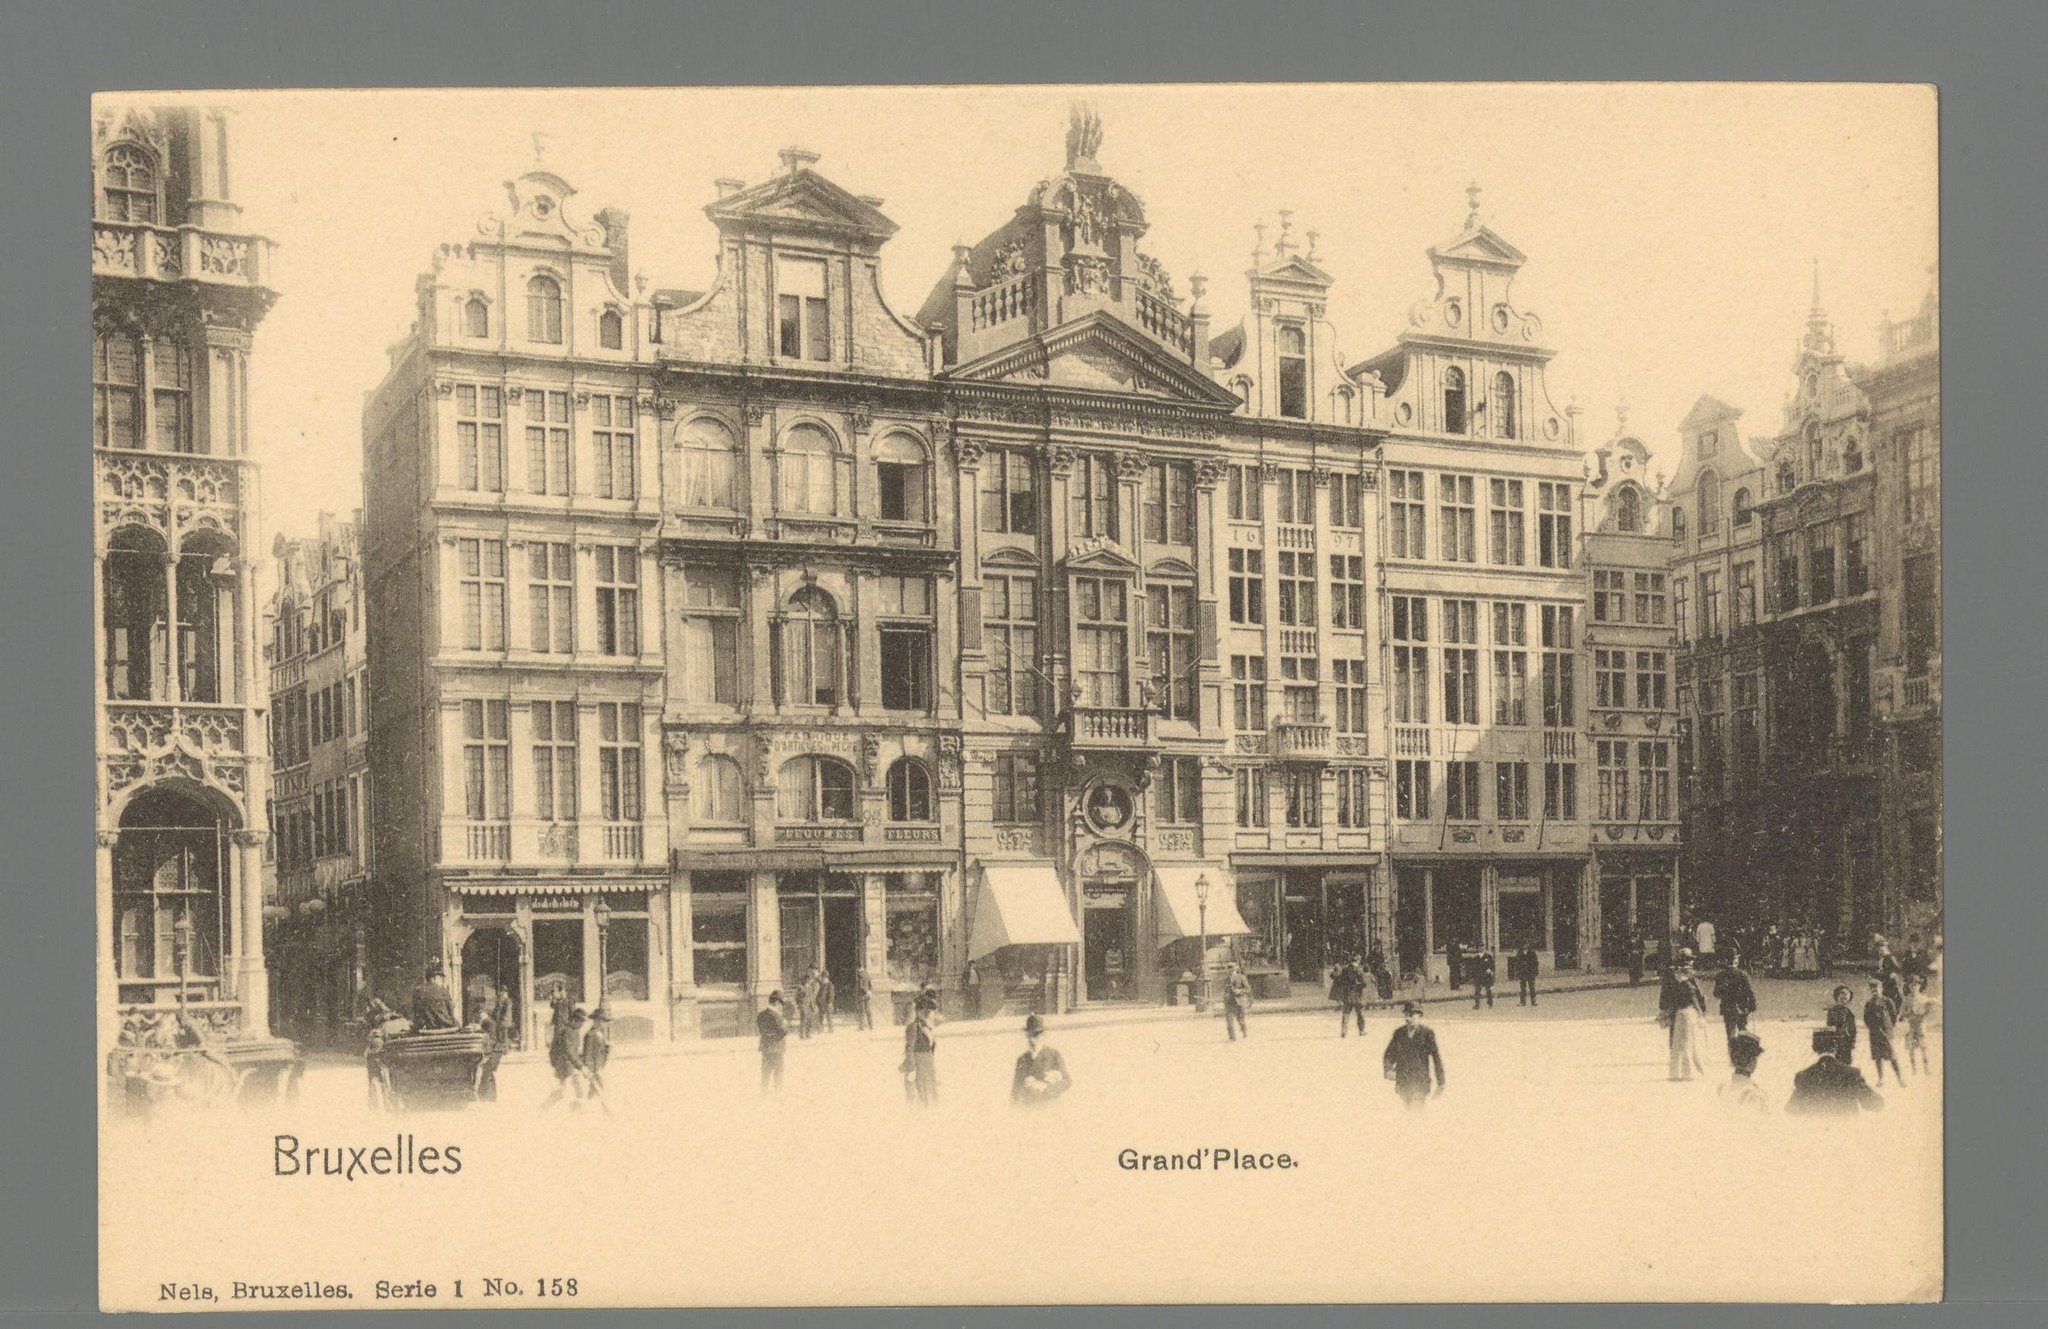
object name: ansichtkaart, prentbriefkaart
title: Serie 1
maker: Anonymous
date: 1898-1906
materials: cardboard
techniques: photograph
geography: brussels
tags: square, place, circus, etc., city-view, and landscape with man-made constructions (+ city(-scape) with figures, staffage)